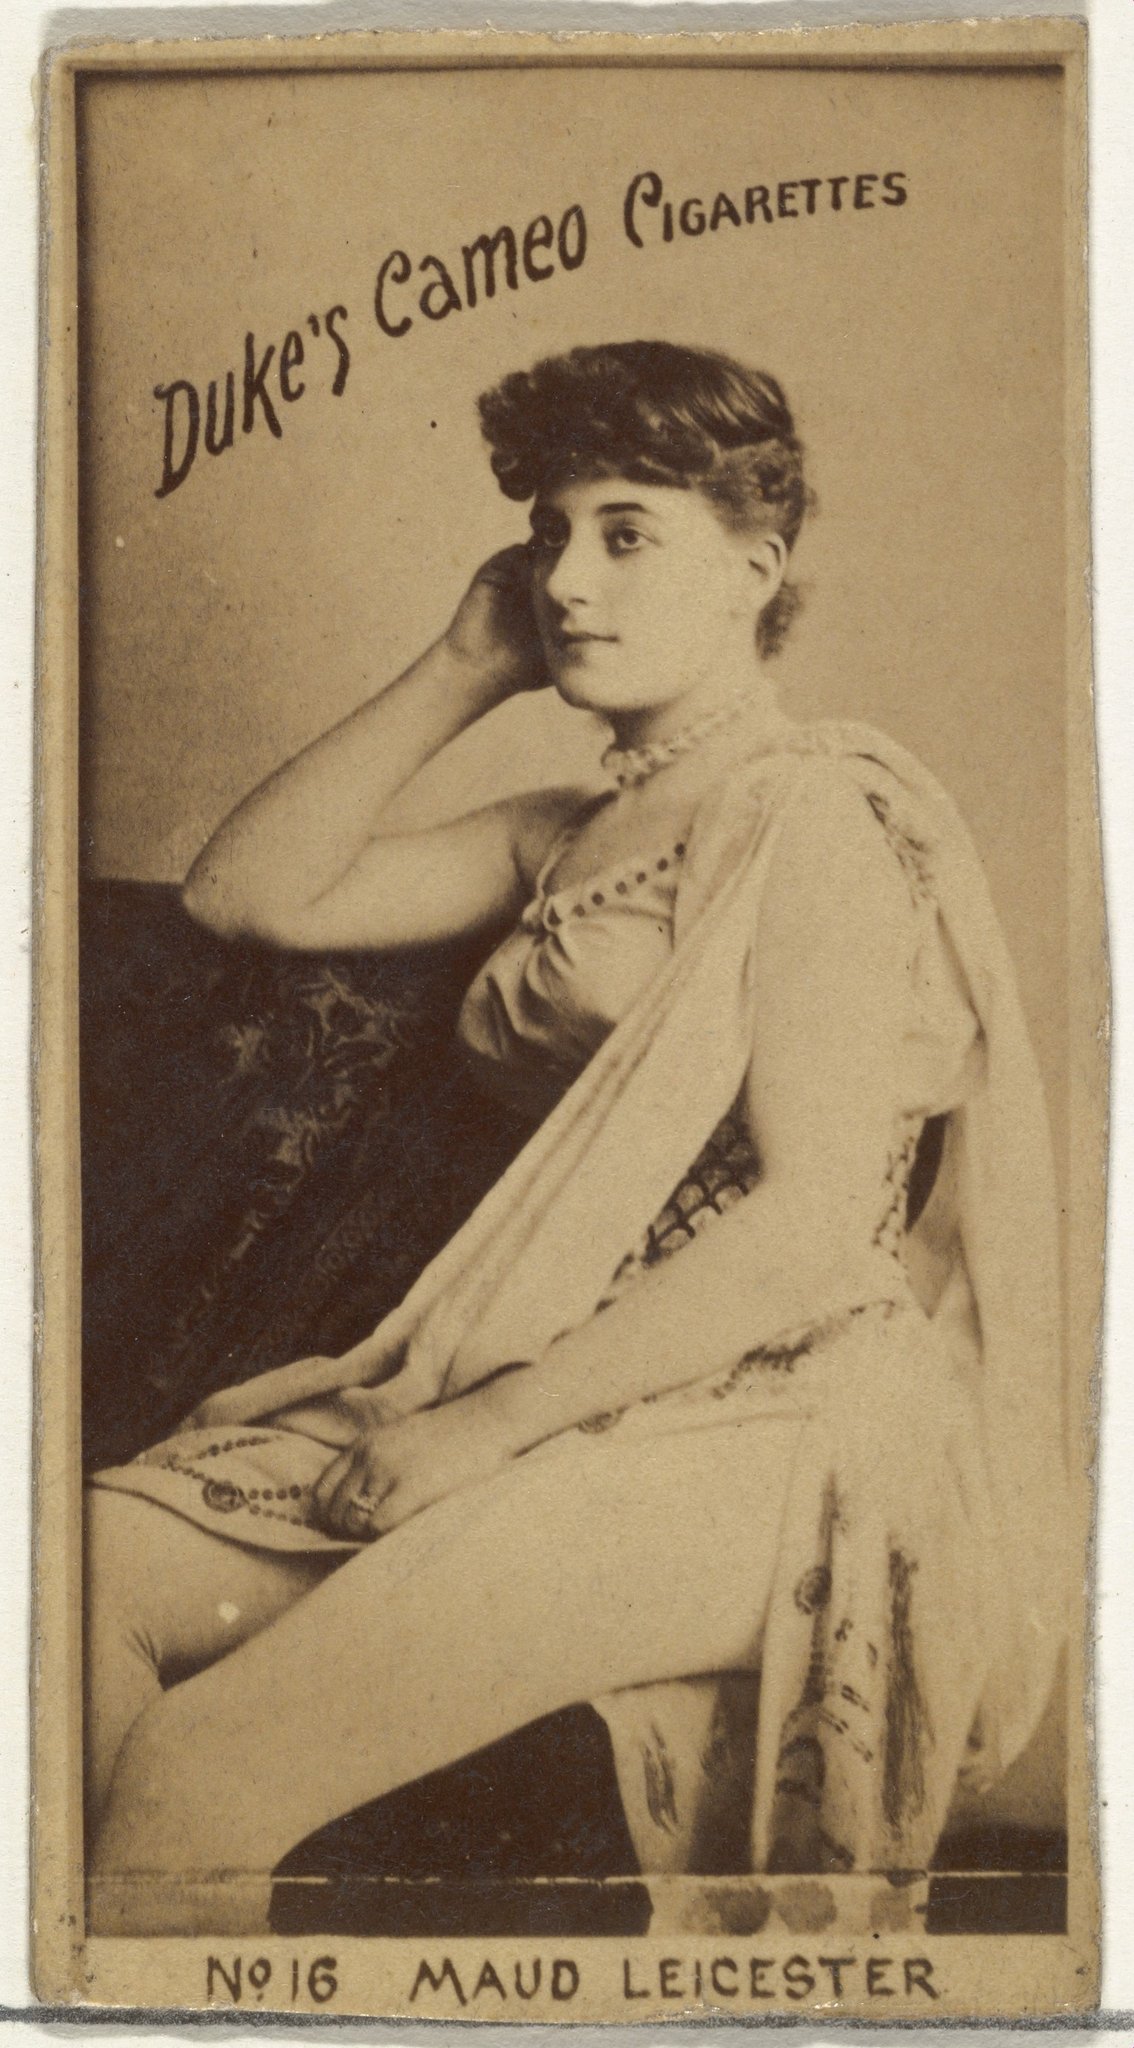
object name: photograph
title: Card Number 16, Maud Leicester, from the Actors and Actresses series (N145-4) issued by Duke Sons & Co. to promote Cameo Cigarettes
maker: w. duke, sons & co.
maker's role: publisher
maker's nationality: american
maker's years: 1870-1920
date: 1880-1889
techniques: albumen silver print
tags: portraits,women,actresses